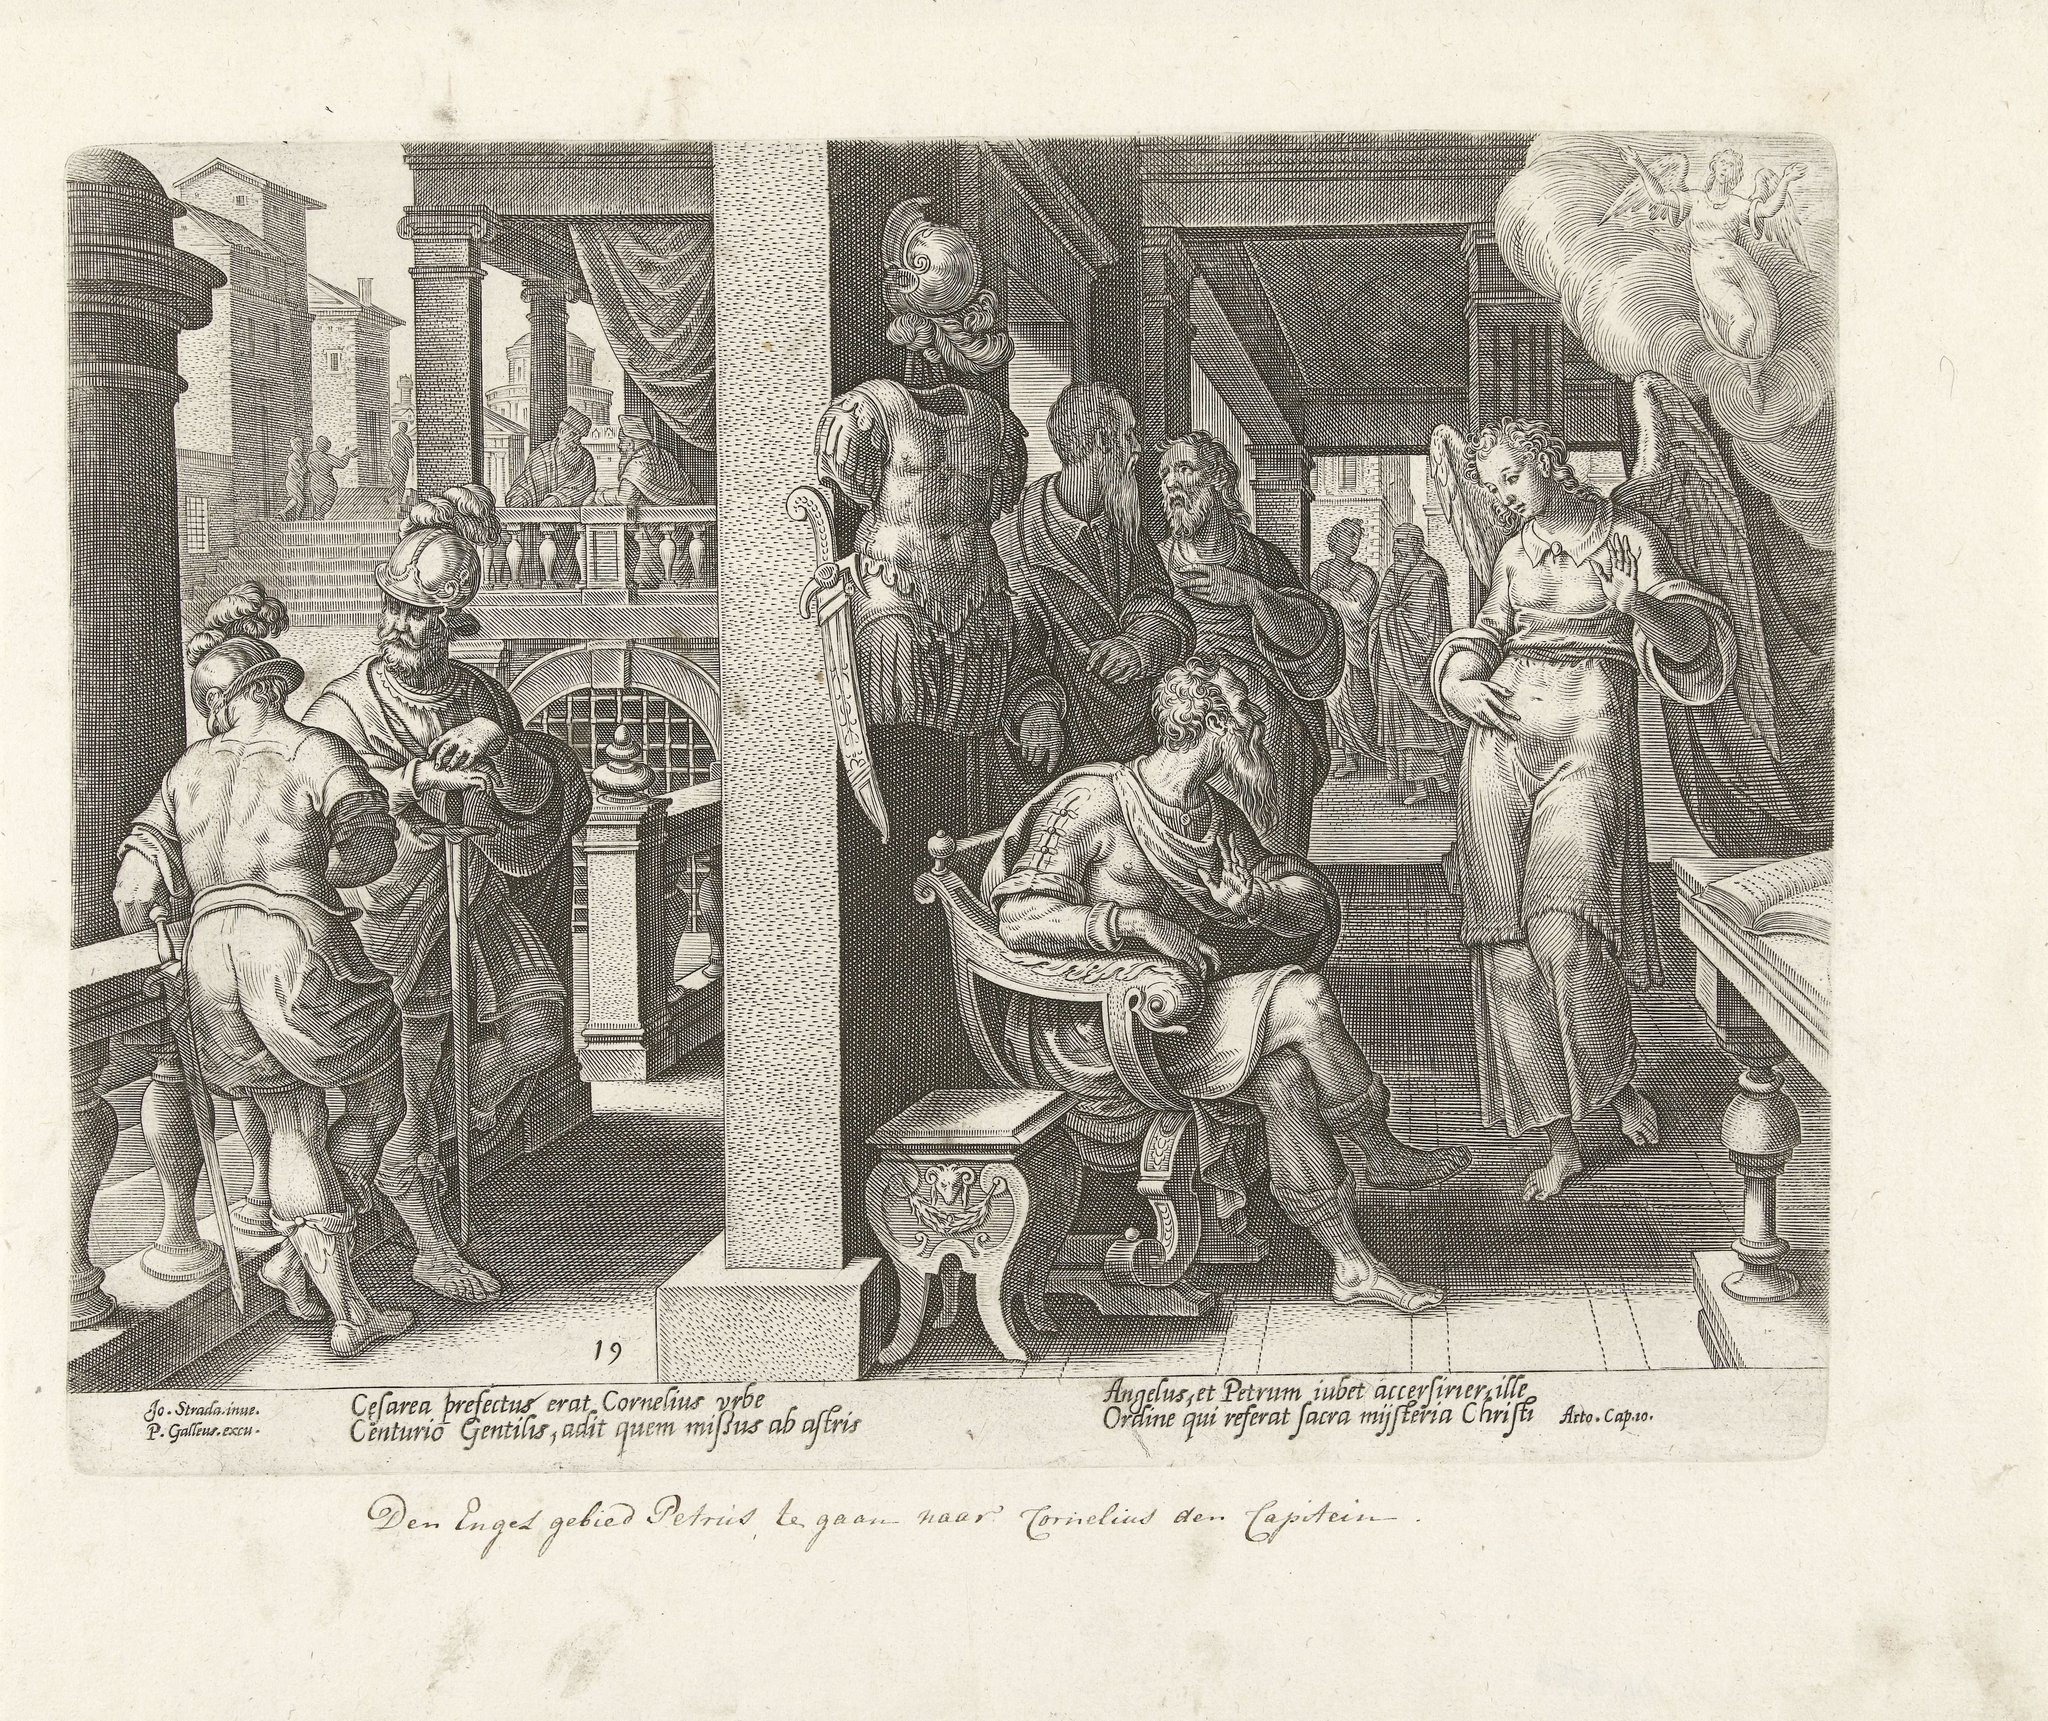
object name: print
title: Acta Apostolorum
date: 1582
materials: paper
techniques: engraving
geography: florence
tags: cornelius sends two servants and a soldier to peter in joppa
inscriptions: caption: ‘Den Engel gebied Petrs te gaan naar Cornelius den Capitein’, collector's mark: Lugt 2228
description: Een engel verschijnt voor Cornelius in een visioen. Hij beveelt hem de apostel Petrus op te zoeken. Twee soldaten worden eropuit gestuurd om Petrus te halen. De prent heeft een Latijns onderschrift en maakt deel uit van een 34-delige serie met als onderwerp de Handelingen van de apostelen.